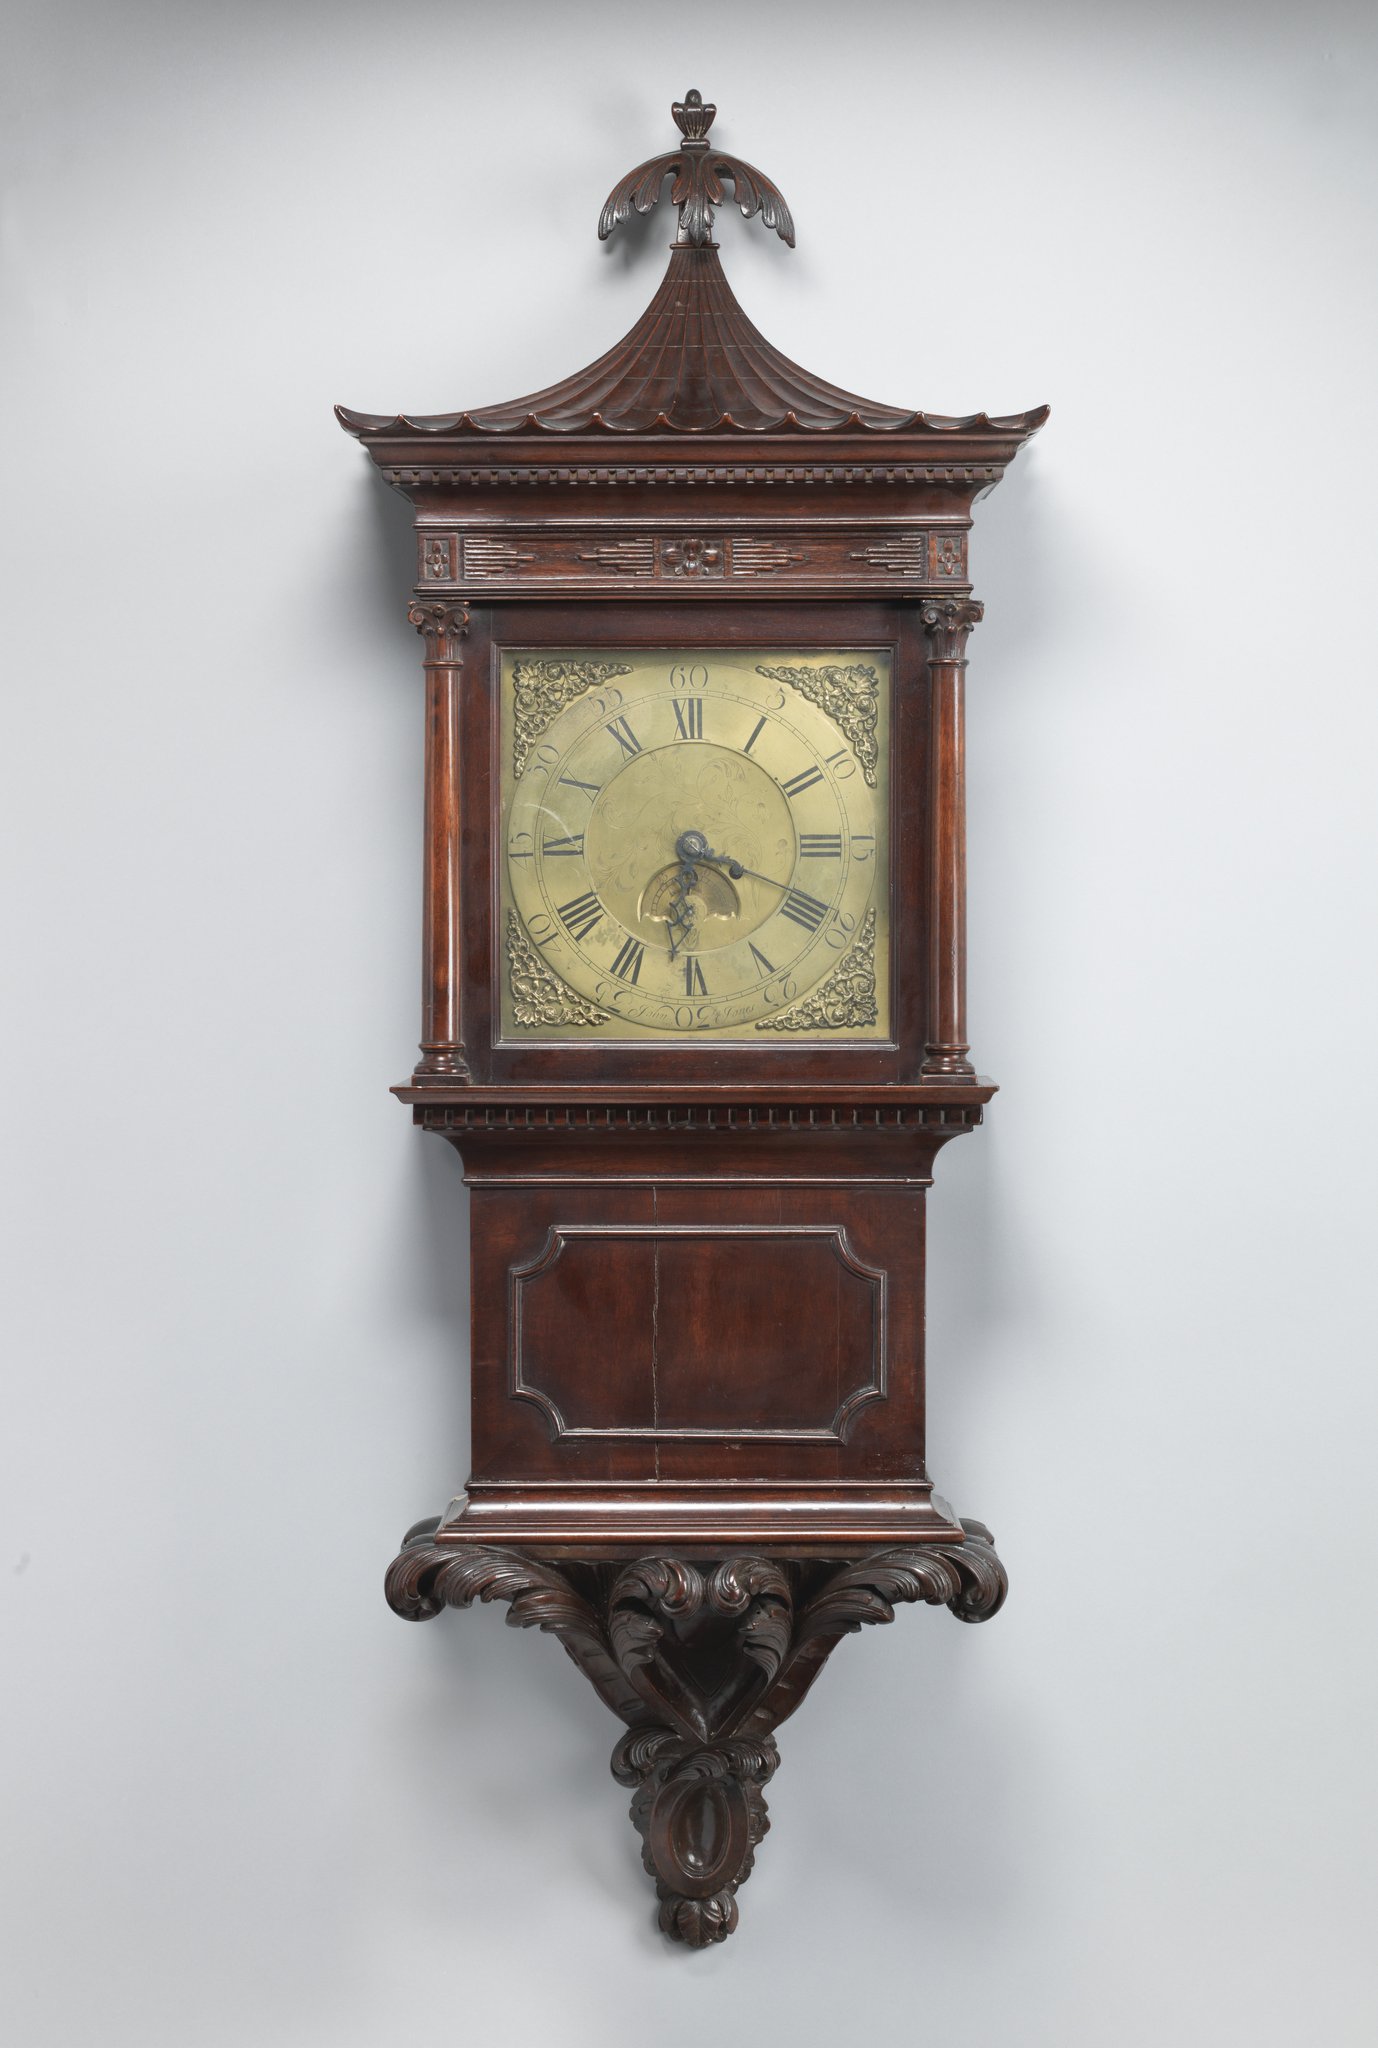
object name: wall clock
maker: john jones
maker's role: maker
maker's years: 1700-1800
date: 1760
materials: wood